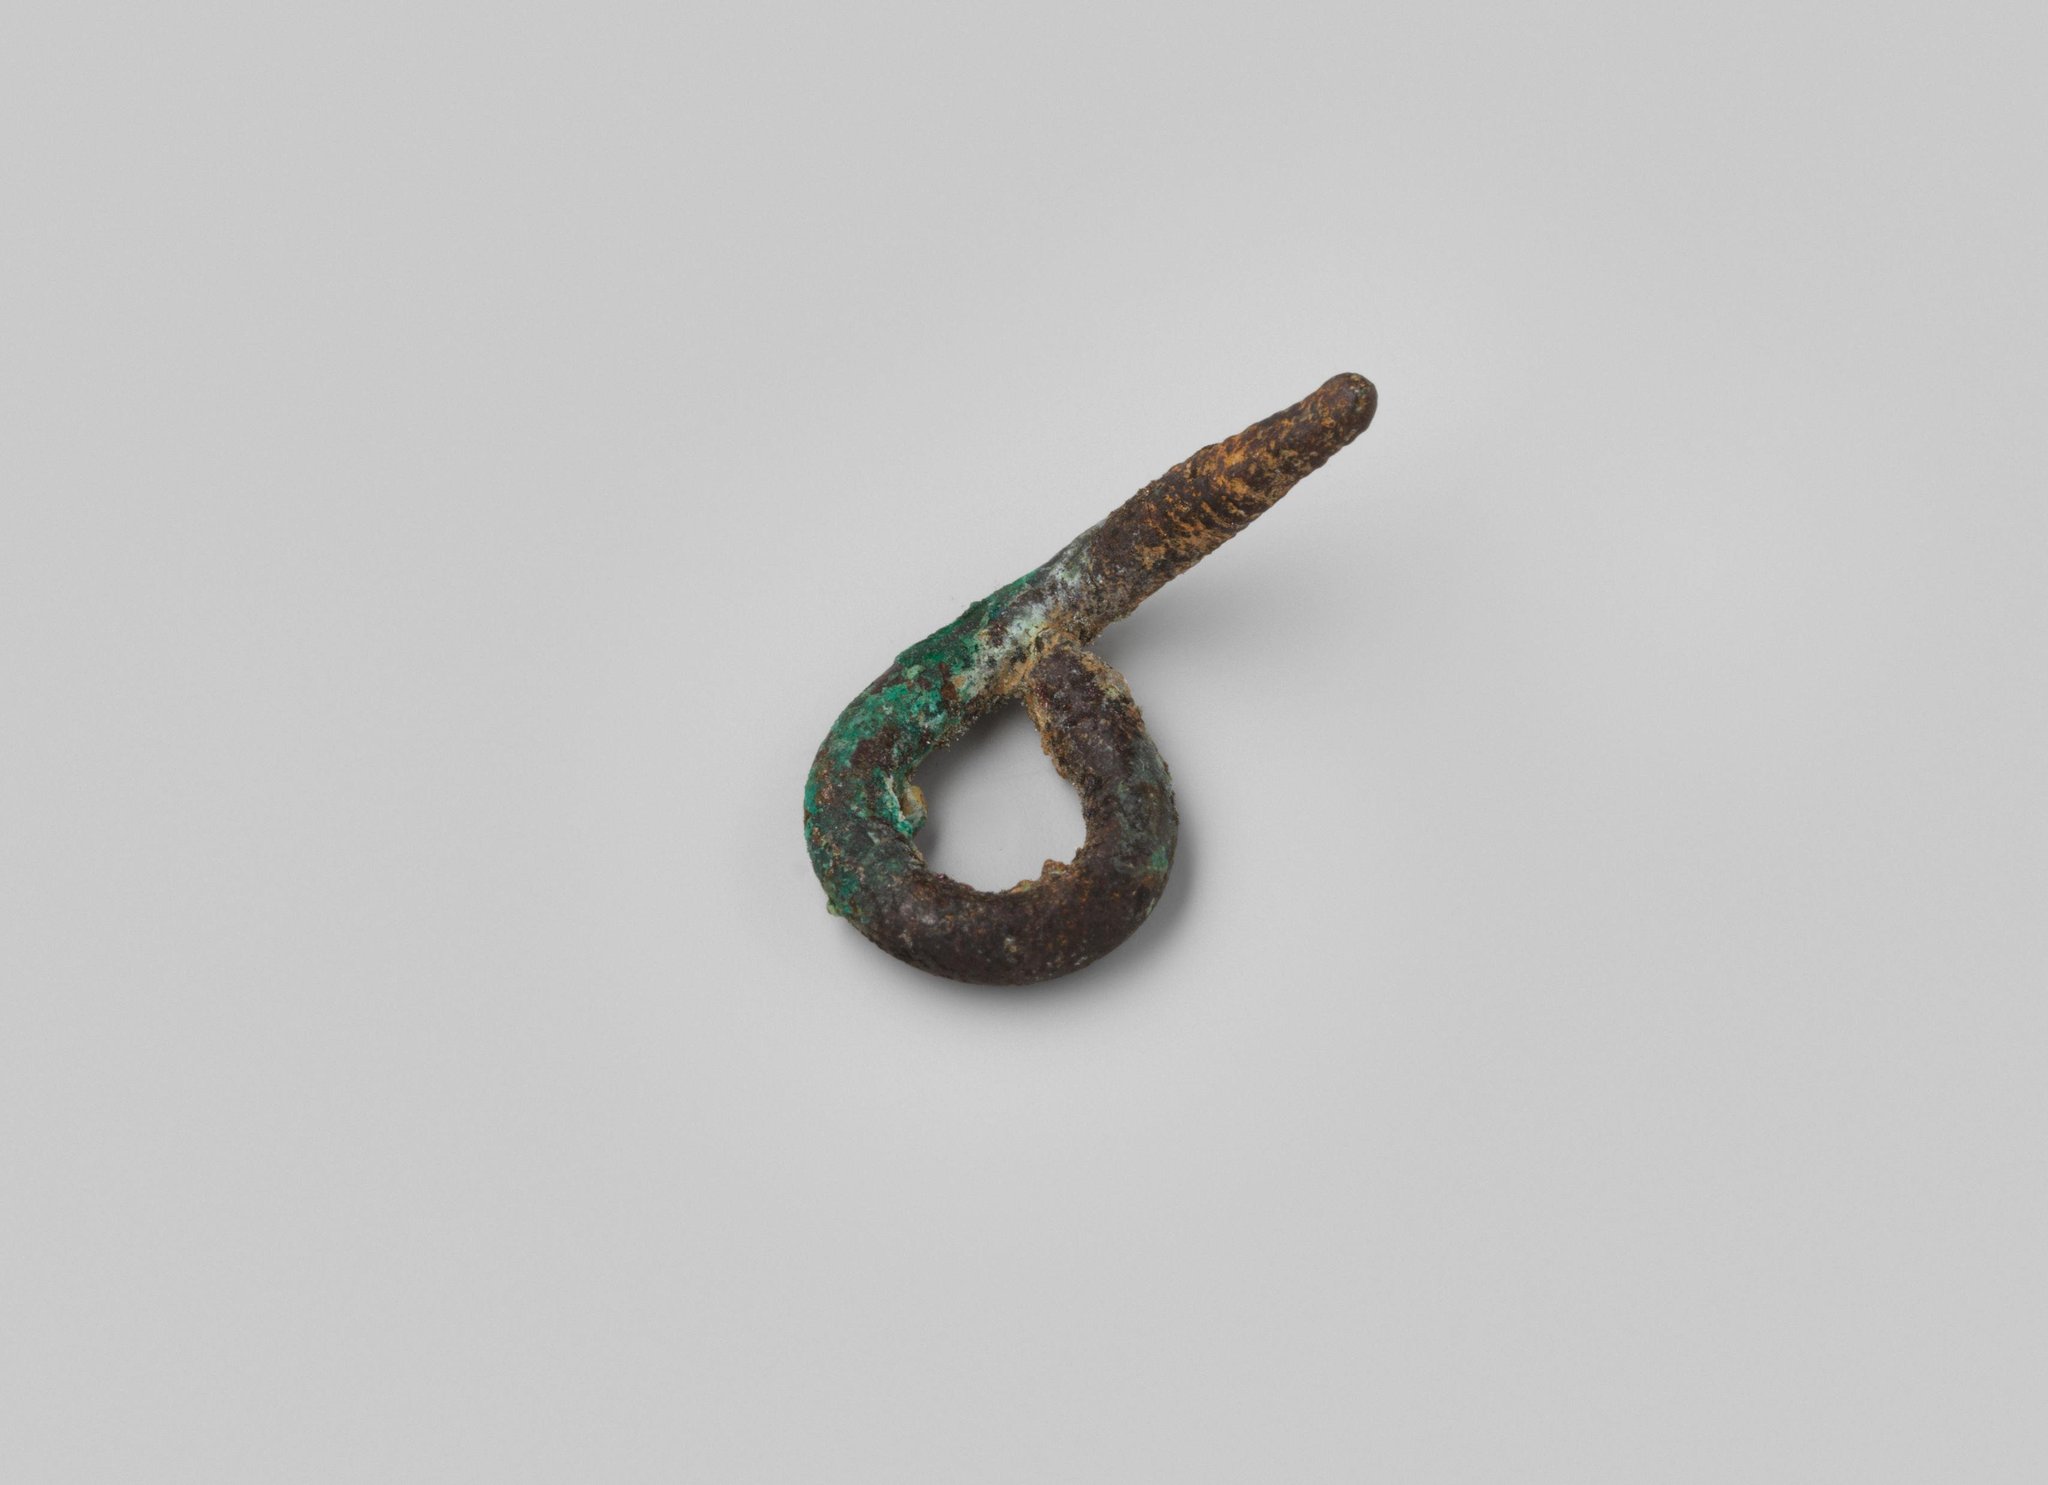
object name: screw eye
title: Schroefoog afkomstig uit het wrak van de Oost-Indiëvaarder Hollandia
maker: Anonymous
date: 1700-1743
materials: copper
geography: netherlands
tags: verenigde oostindische compagnie, hollandia (schip)